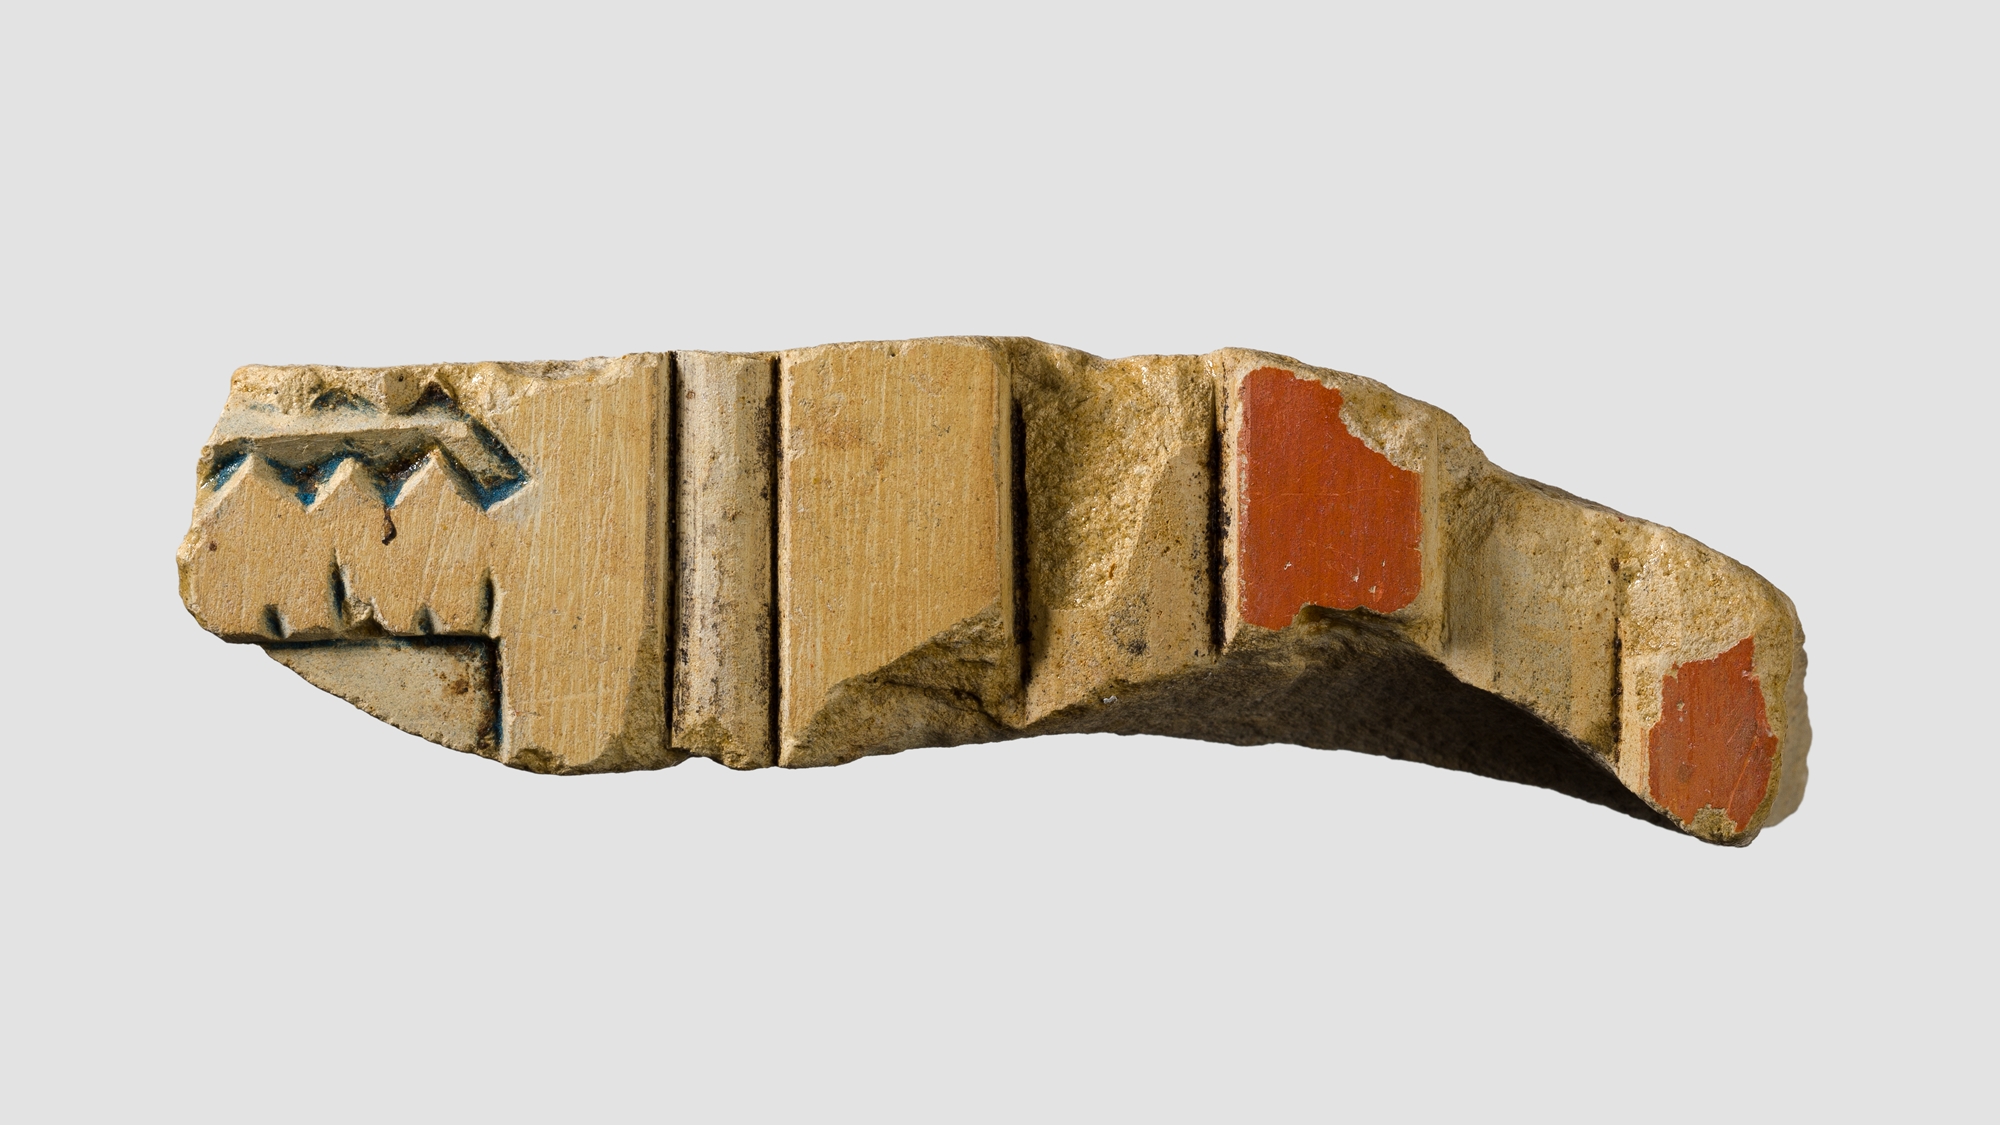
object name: relief fragment, neferu or khety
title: Relief Fragment from the Tomb Neferu or Khety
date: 2030-1640 BCE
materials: limestone, paint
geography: egypt